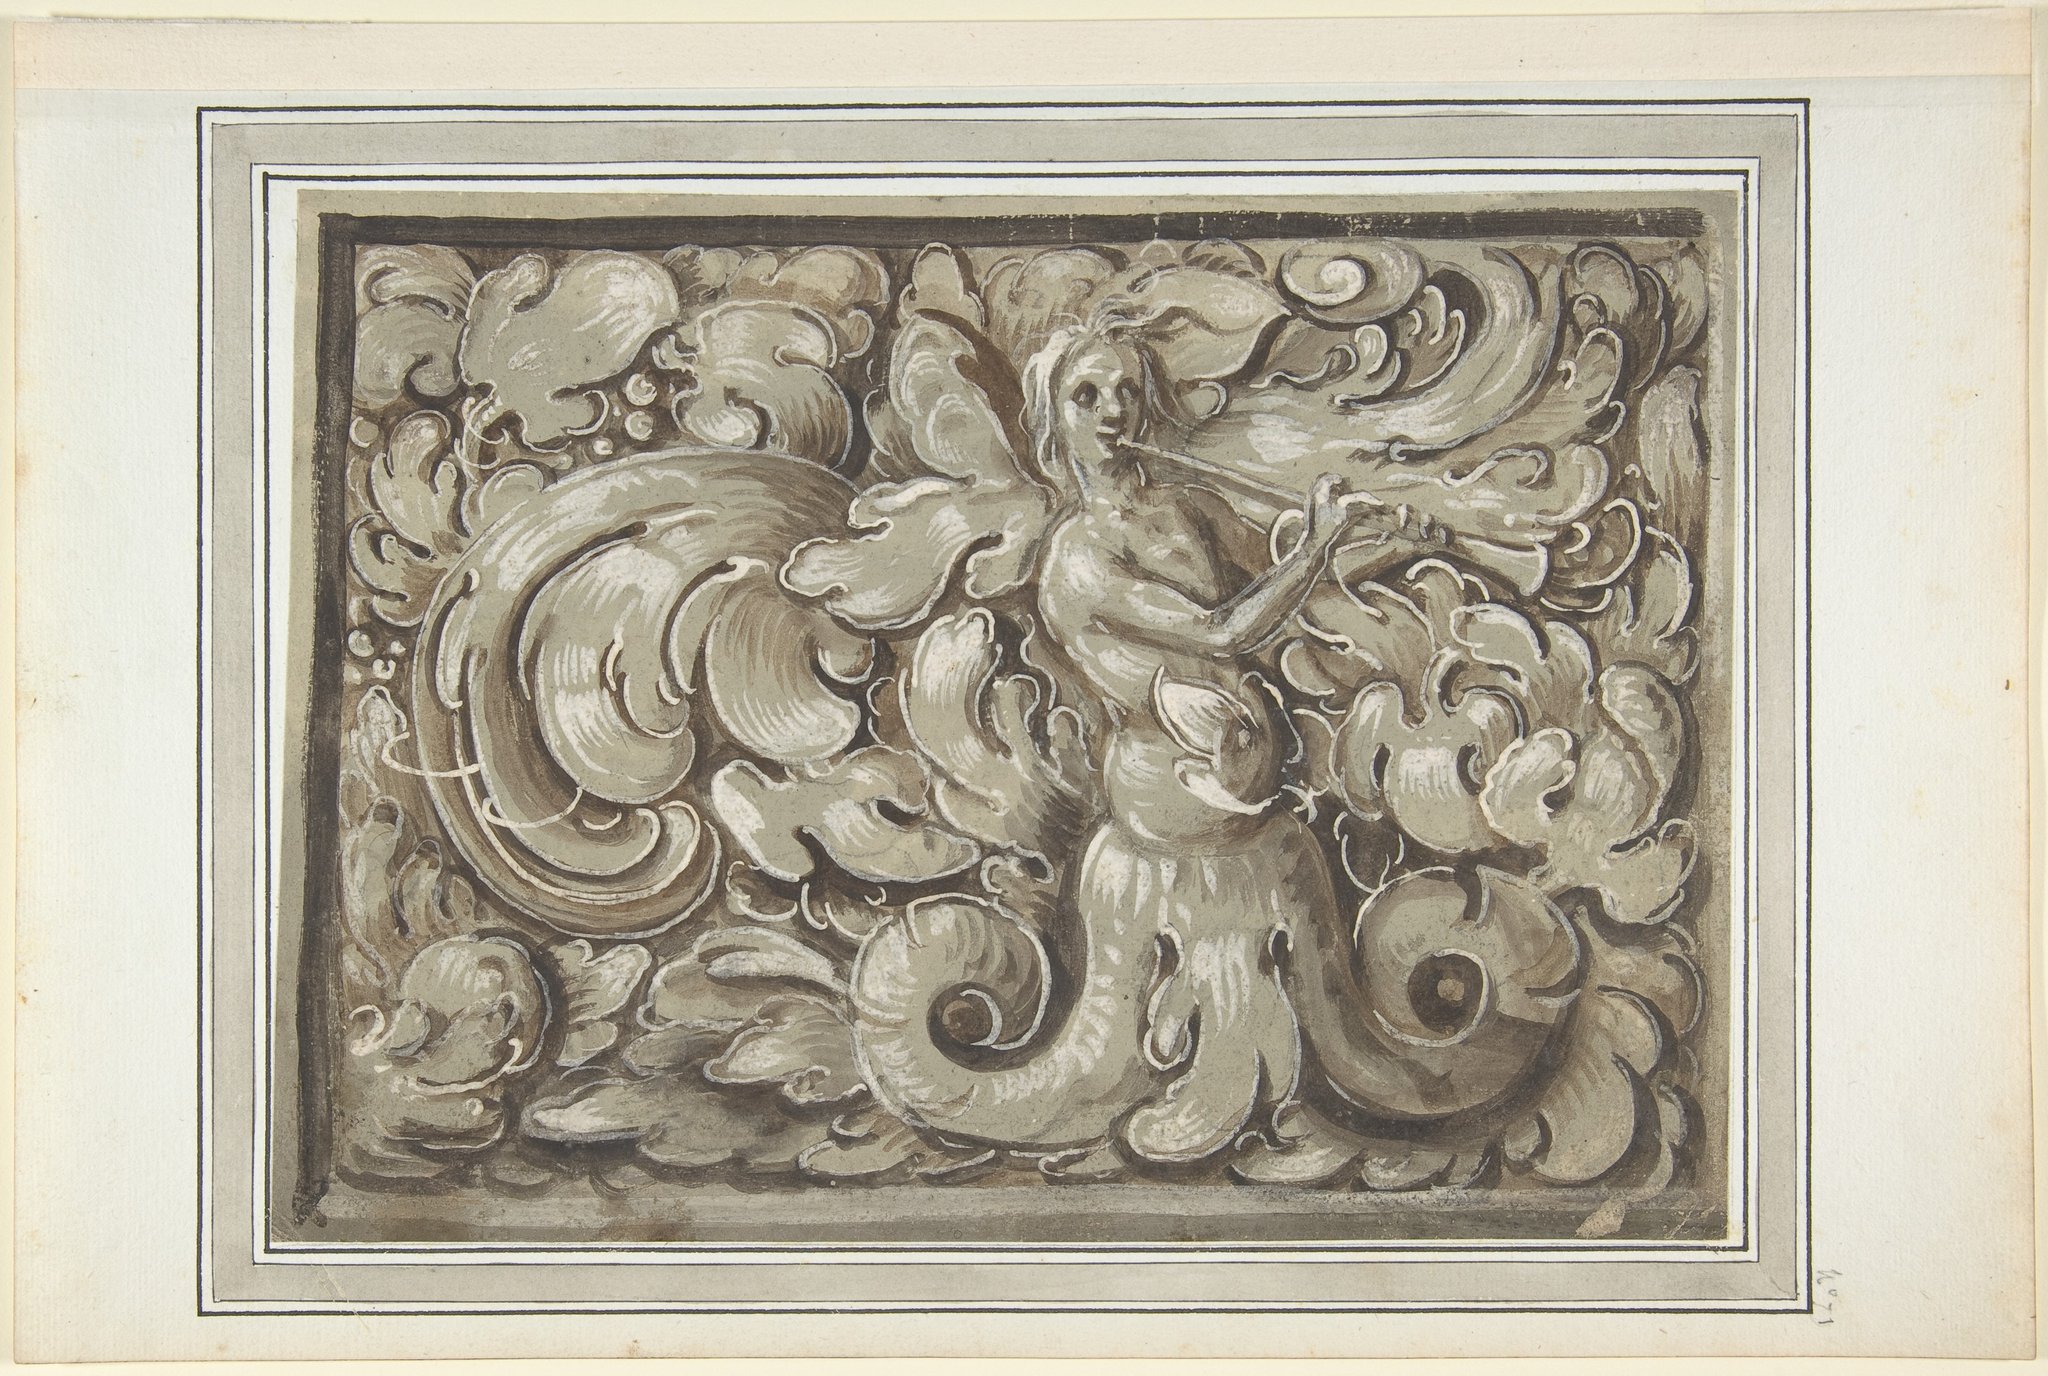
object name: drawing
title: Nymph Playing a Horn (recto); Bracket with a Man's Head (verso)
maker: anonymous, german, 16th century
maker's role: artist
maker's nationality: german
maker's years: 1500-1600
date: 1501-1600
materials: chalk, gouache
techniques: brush, heightening, wash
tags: heads,horns,nymphs